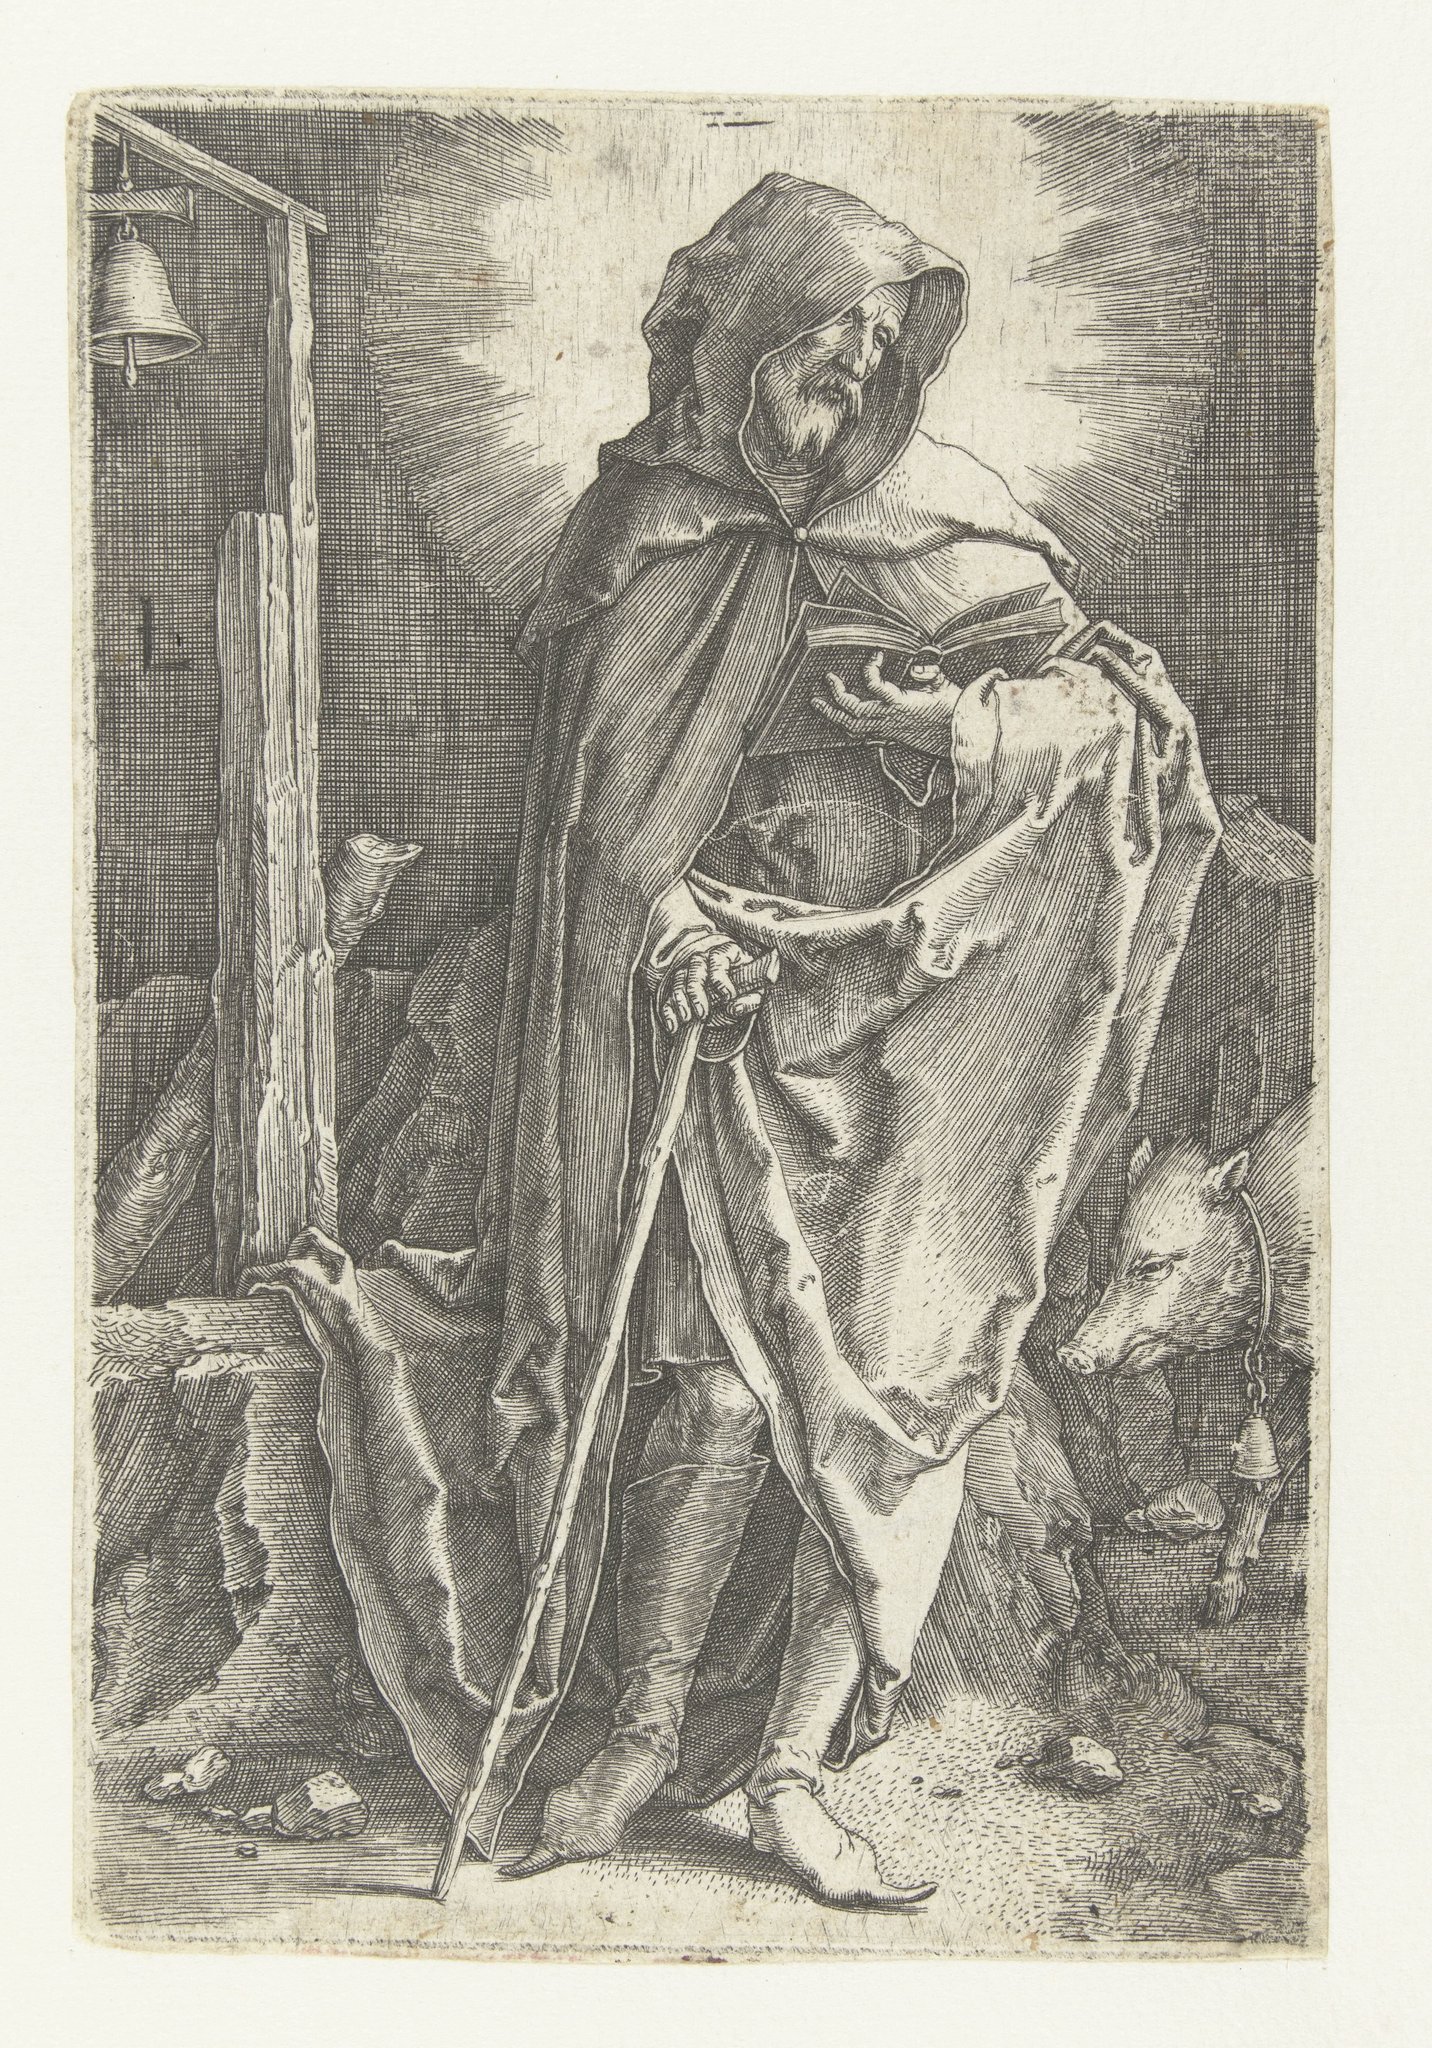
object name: print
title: De heilige Antonius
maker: lucas van leyden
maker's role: draughtsman, painter, print maker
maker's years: 1494-1533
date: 1519-1523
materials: paper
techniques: engraving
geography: low countries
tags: the hermit antony abbot (antonius abbas) of egypt, also called the great; possible attributes: bell, book, t-shaped staff, flames, pig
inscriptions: collector's mark: Lugt 2228a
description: Heilige Antonius met wandelstok en boek, links van hem een varken met een bel om de nek.